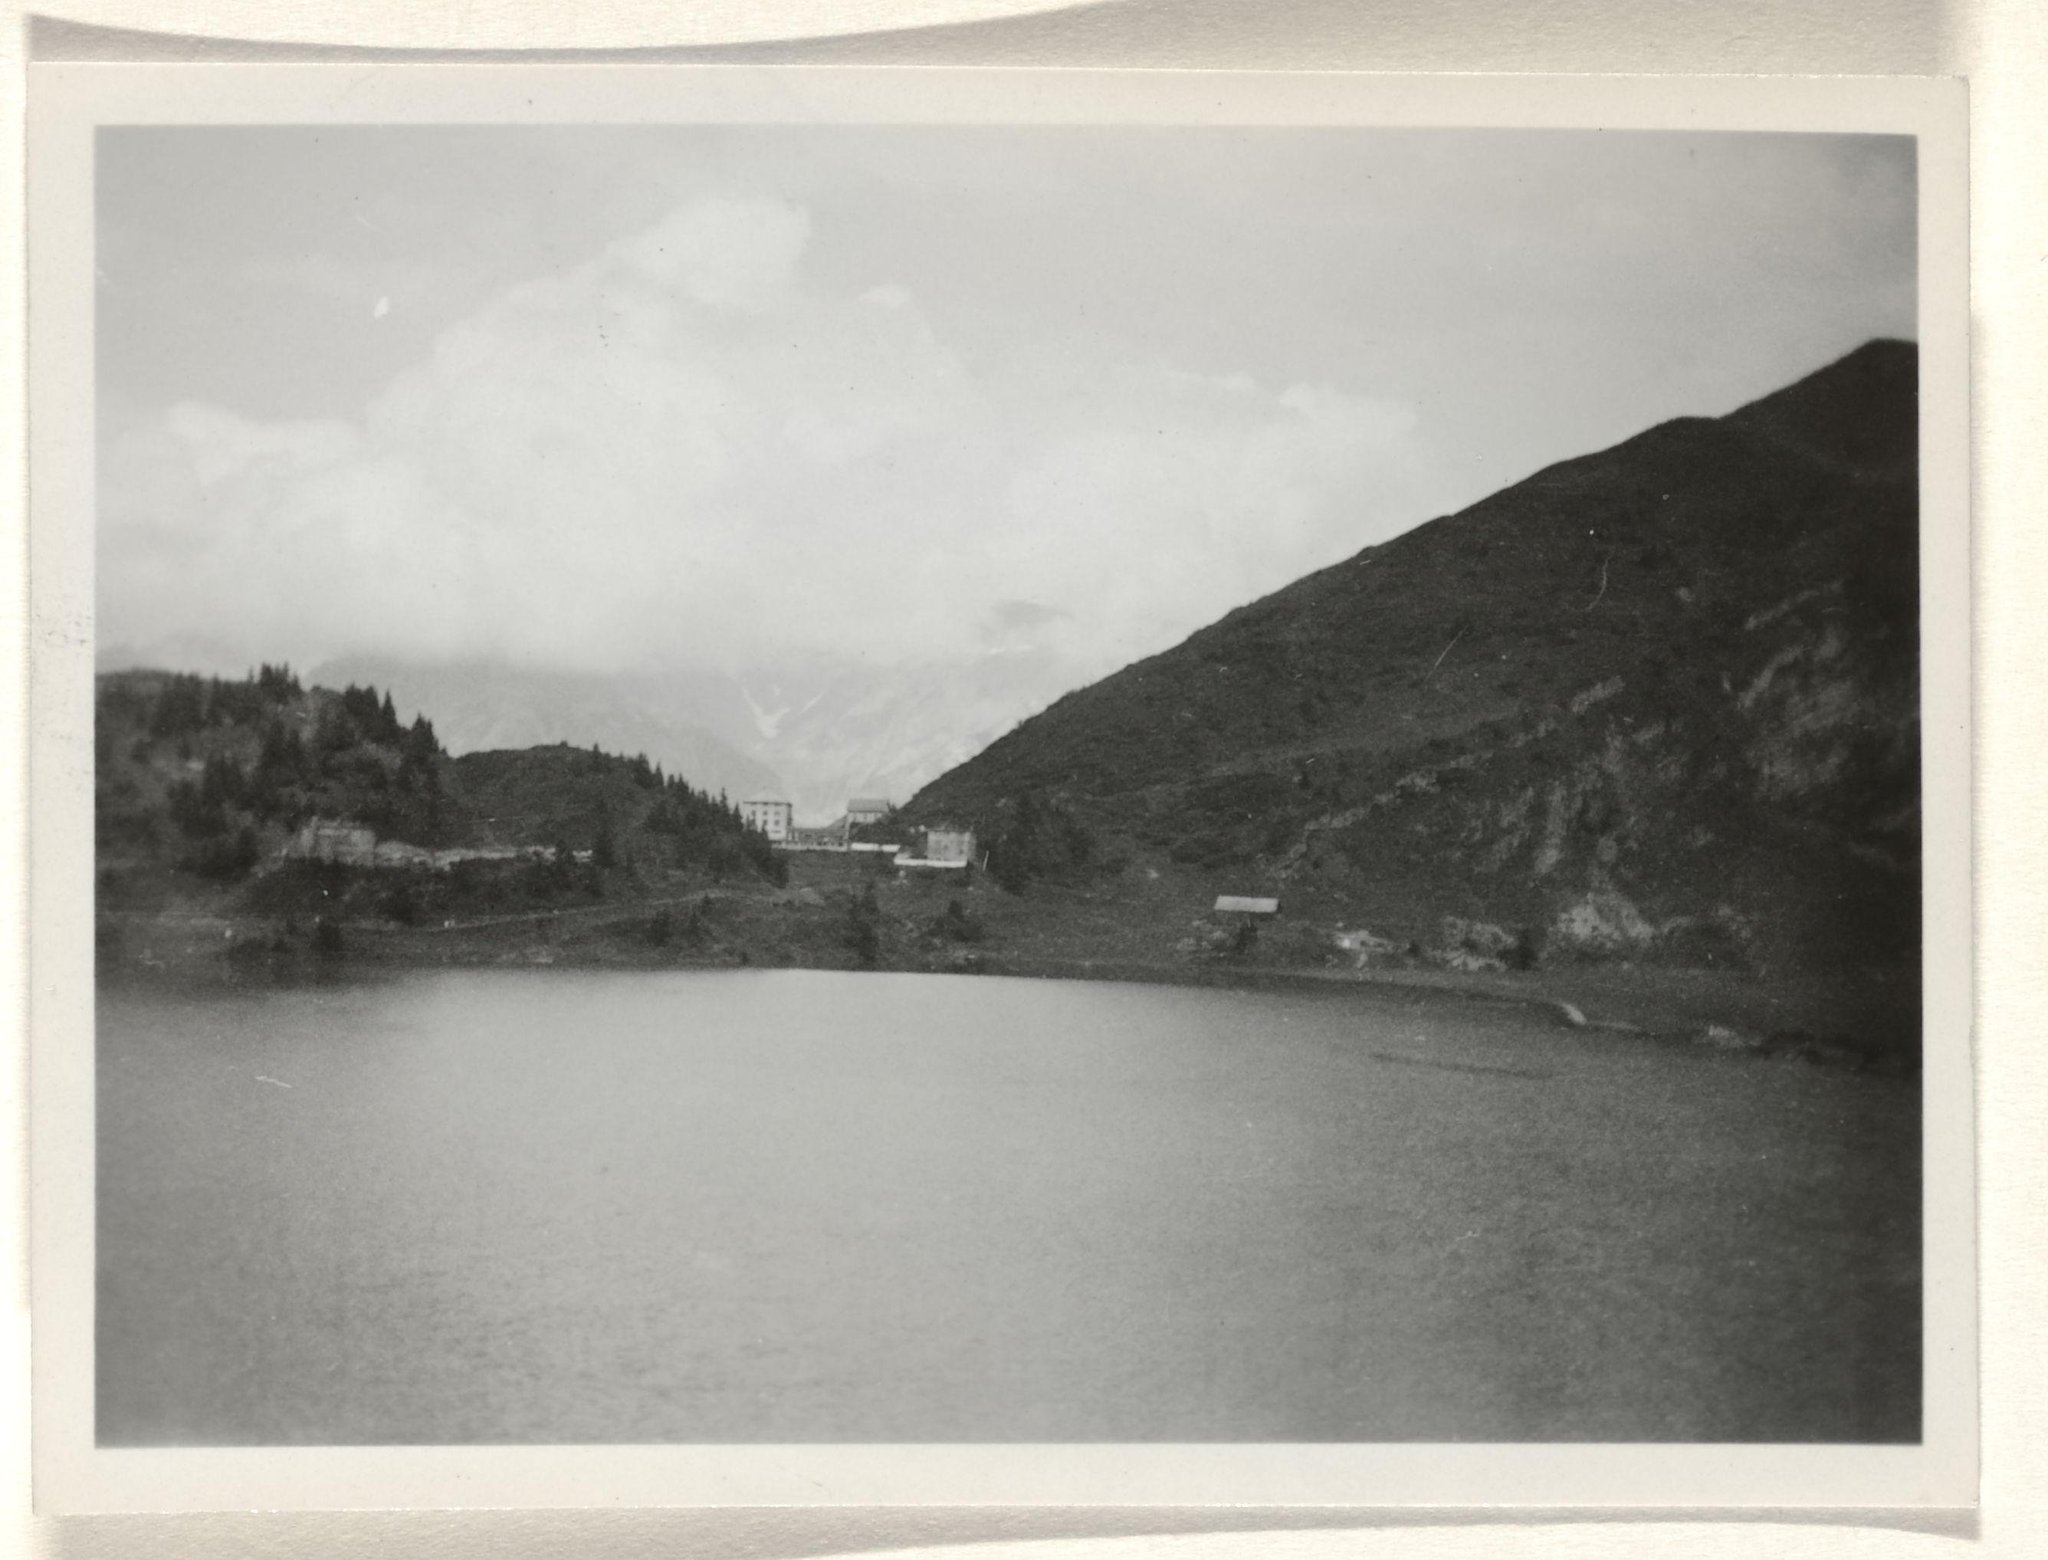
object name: photograph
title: Hotel bij de Zwitserse plaats Engelberg, gezien vanaf het meer, met bergen op de achtergrond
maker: Anonymous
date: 1908-1935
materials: photographic support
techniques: gelatin silver print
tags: trübsee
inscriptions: date: ‘Aug. 1935 Trübsee-Hotel (vom See aus gesehen)’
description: Hotel bij de Zwitserse plaats Engelberg, gezien vanaf het meer, met bergen op de achtergrond.